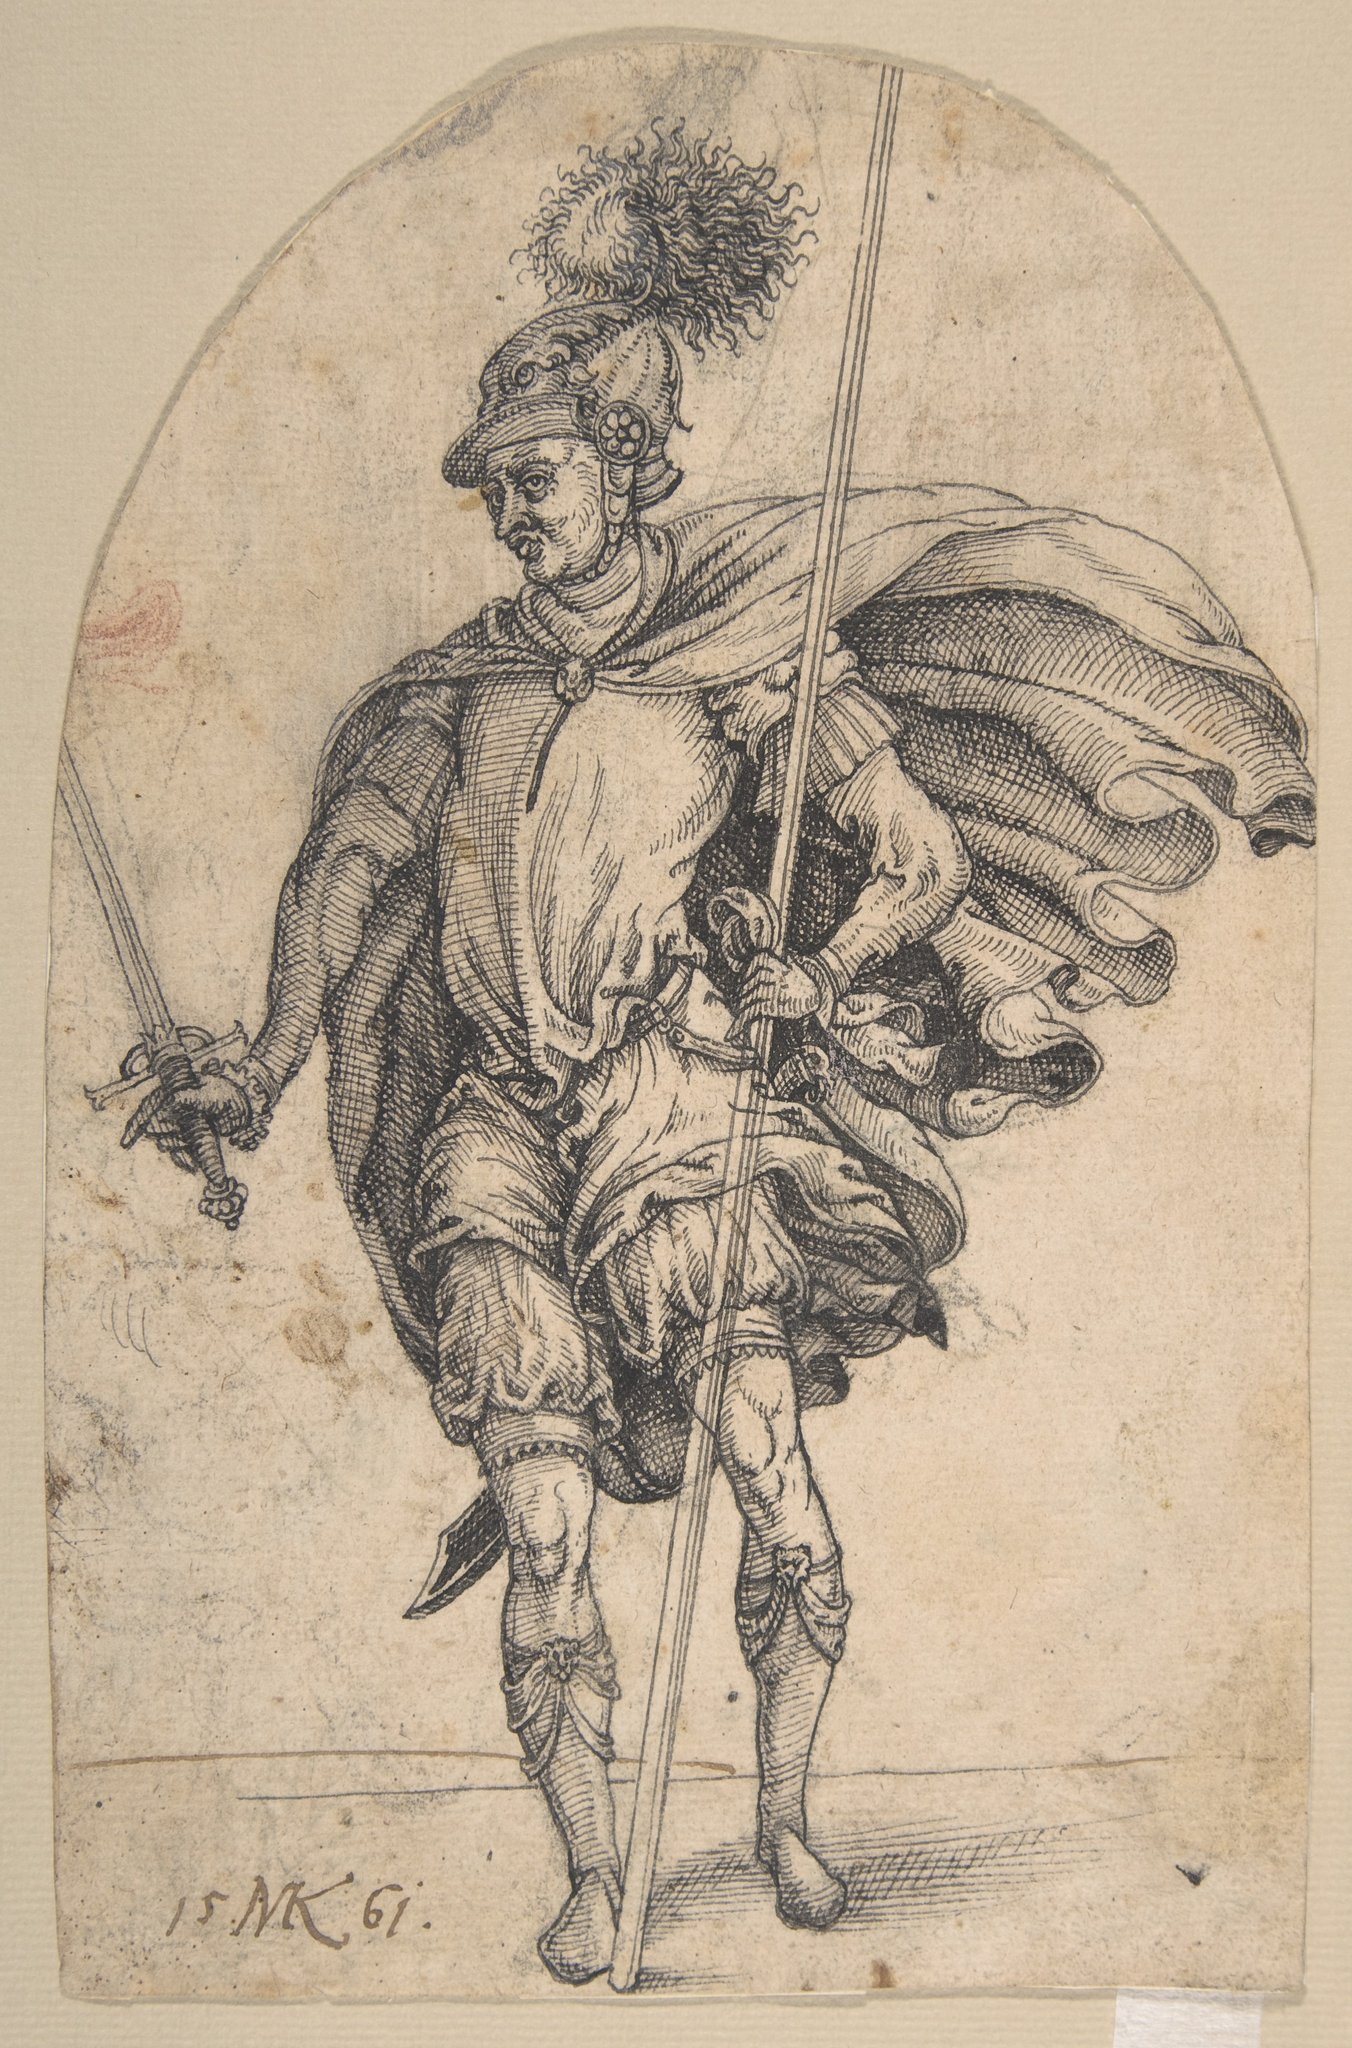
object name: drawing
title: A Standing Soldier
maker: michel kirmer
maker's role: artist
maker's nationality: german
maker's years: 1552-1570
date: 1561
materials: chalk, ink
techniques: pen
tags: soldiers